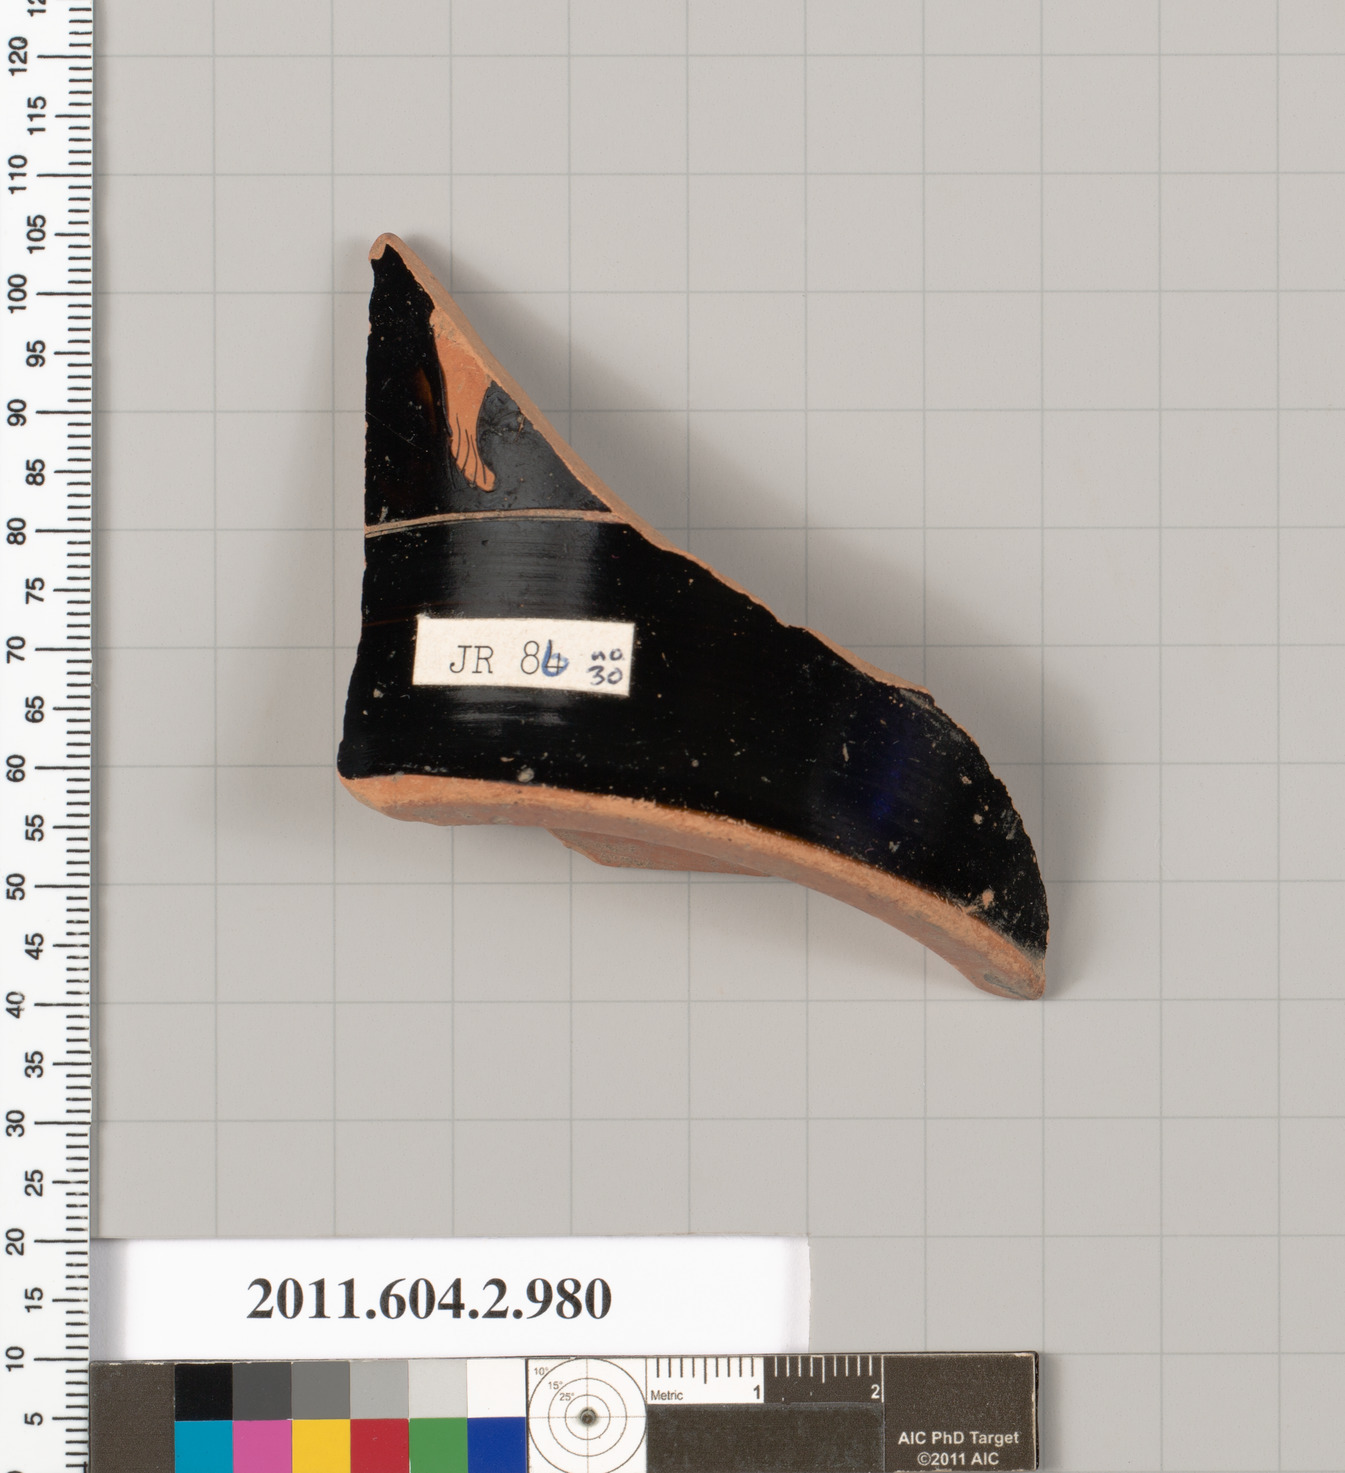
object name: oinochoe fragment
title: Terracotta fragment of an oinochoe (jug)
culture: greek, attic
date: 460-450 BCE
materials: terracotta